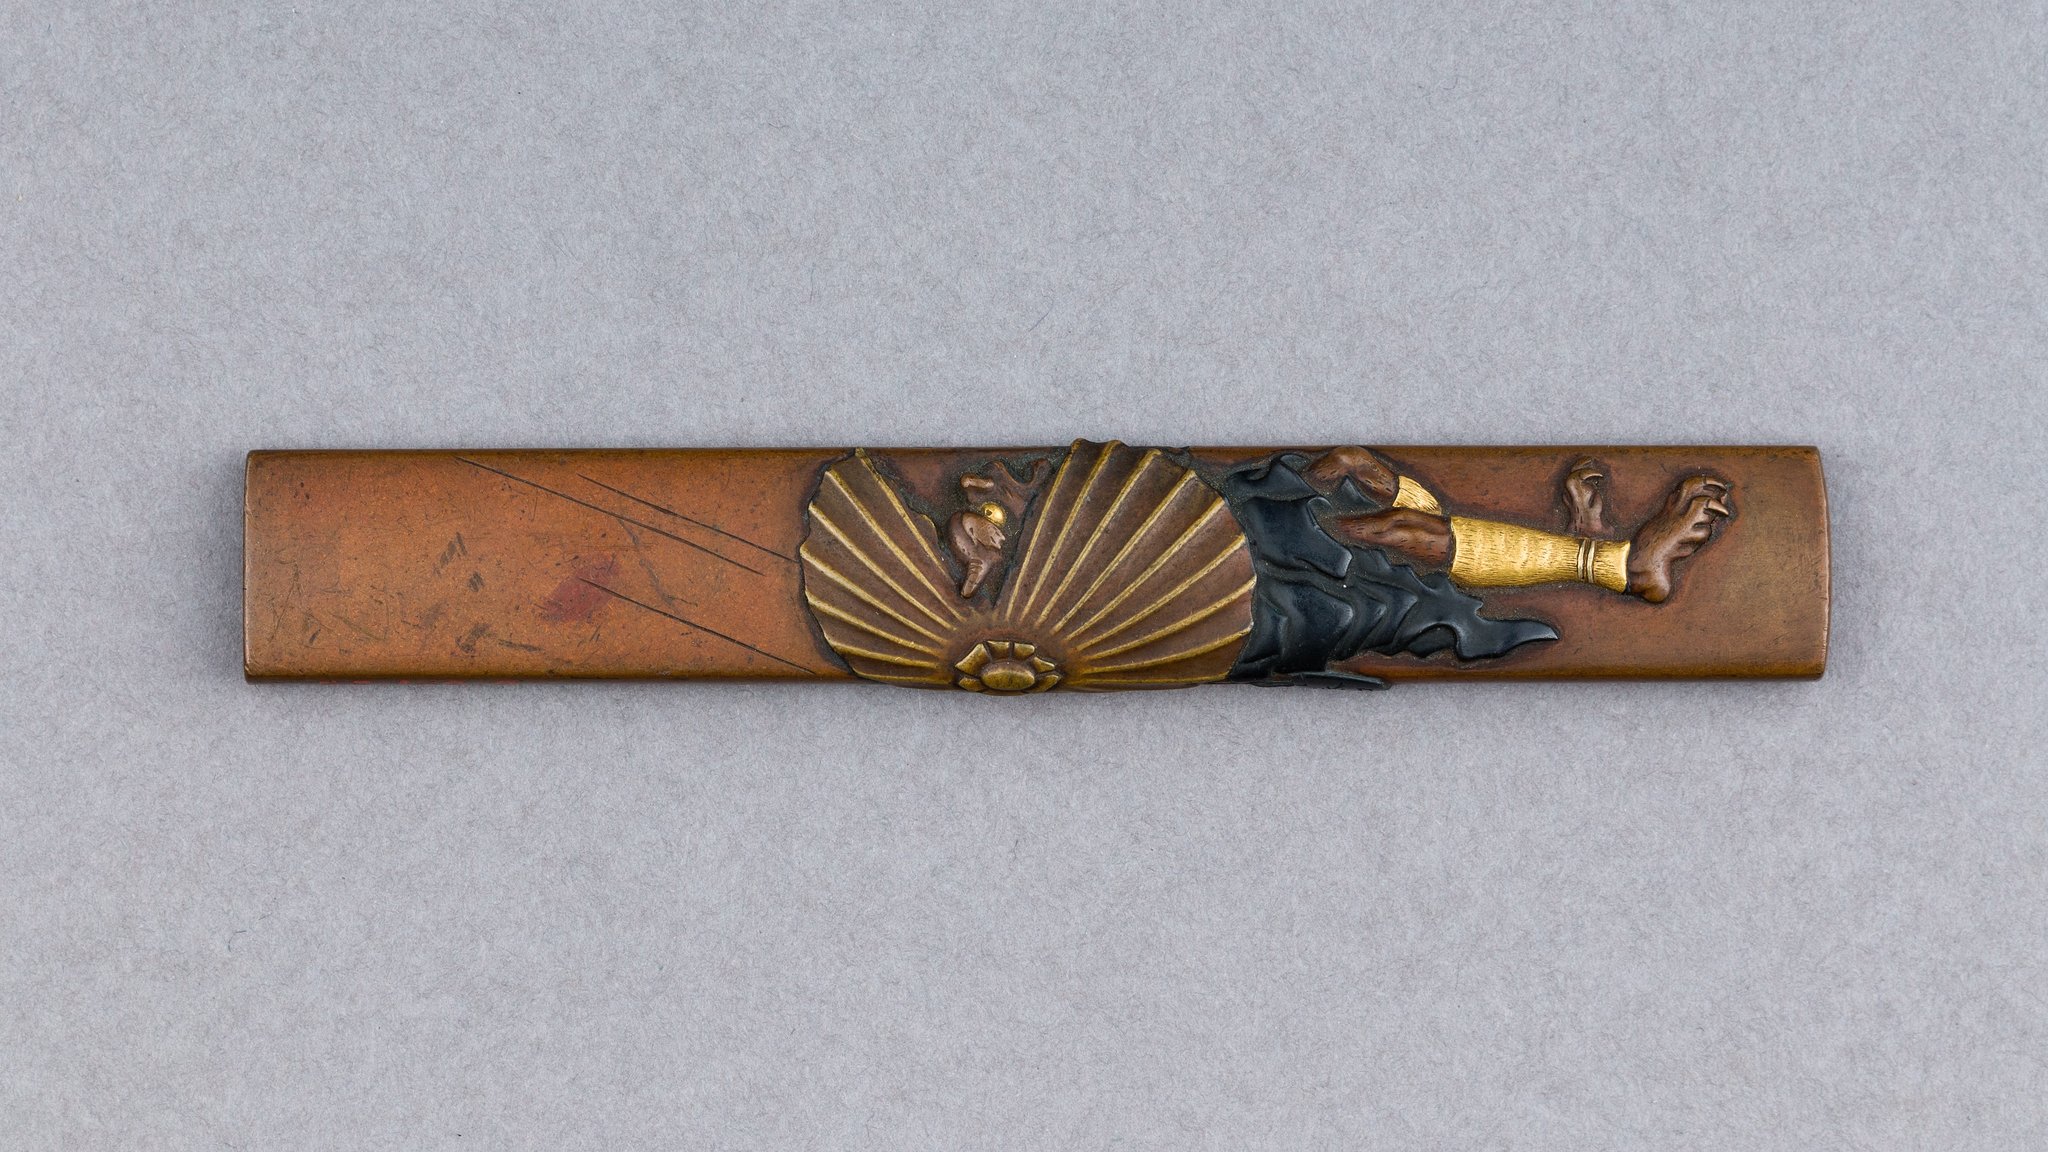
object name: knife handle kozuka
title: Knife Handle (Kozuka)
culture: japanese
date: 1701-1800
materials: brass, copper, gold alloy, gold, silver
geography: japan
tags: demons